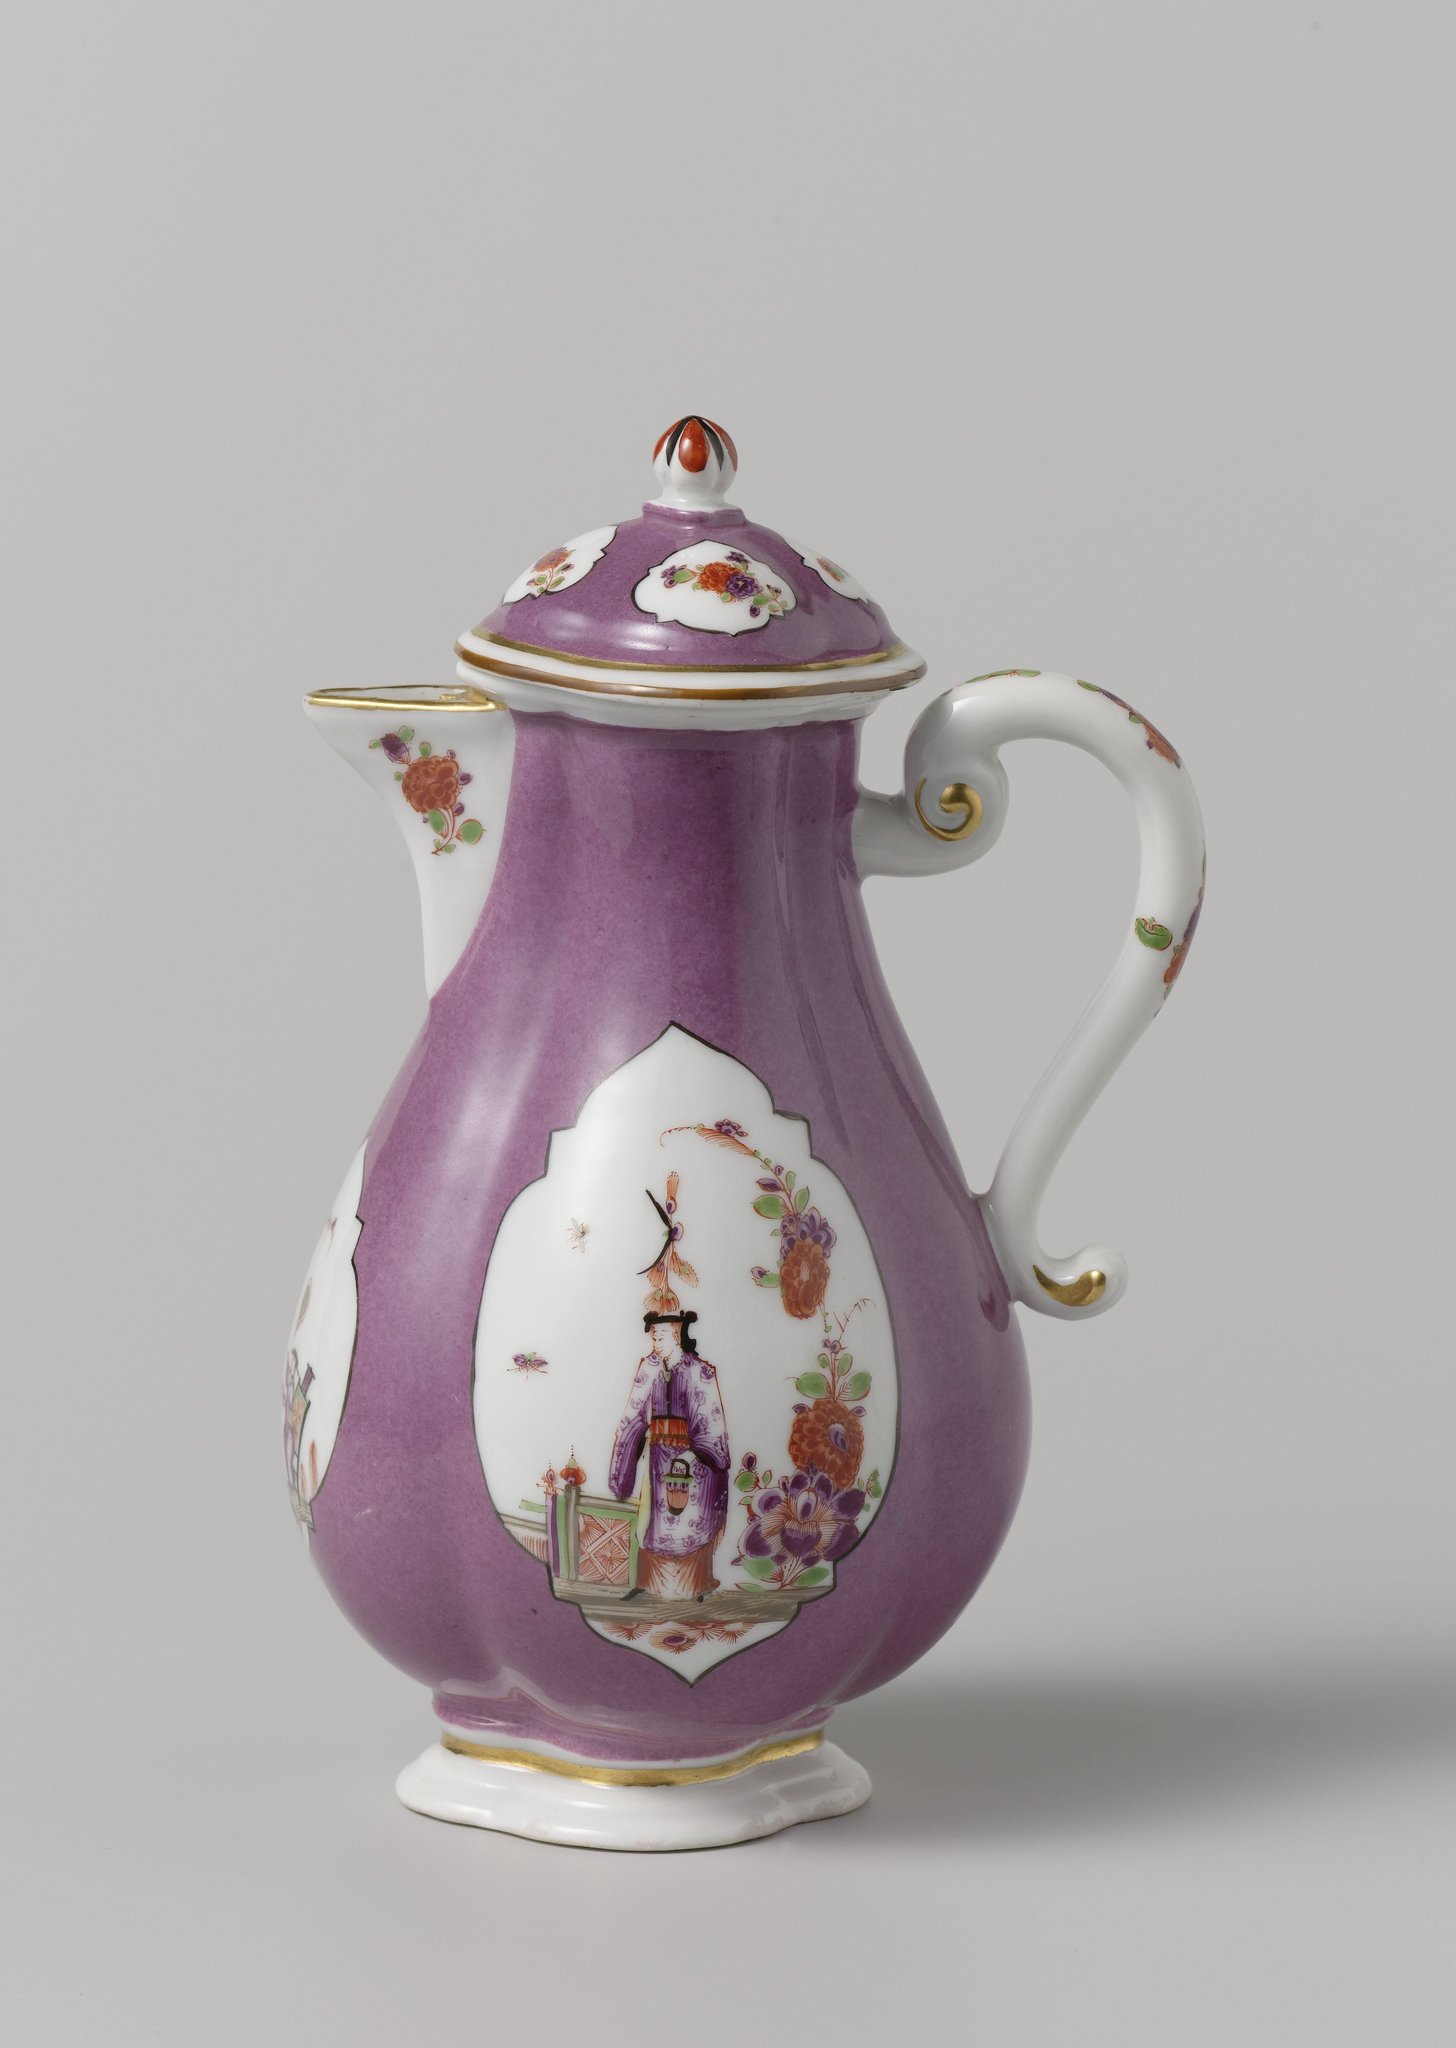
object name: eating drinking utensil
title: Koffiekan met deksel, veelkleurig beschilderd met Chinezen in uitgespaarde vierpassen in een violette fond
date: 1730-1735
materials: porcelain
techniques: painted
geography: meissen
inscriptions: label: ‘SAMMLUNG / Dr. FRANZ OPPENHEIMER’, number: ‘118.’, factory mark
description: Coffee pot. Porcelain. Meissen, c. 1730 - 1735.